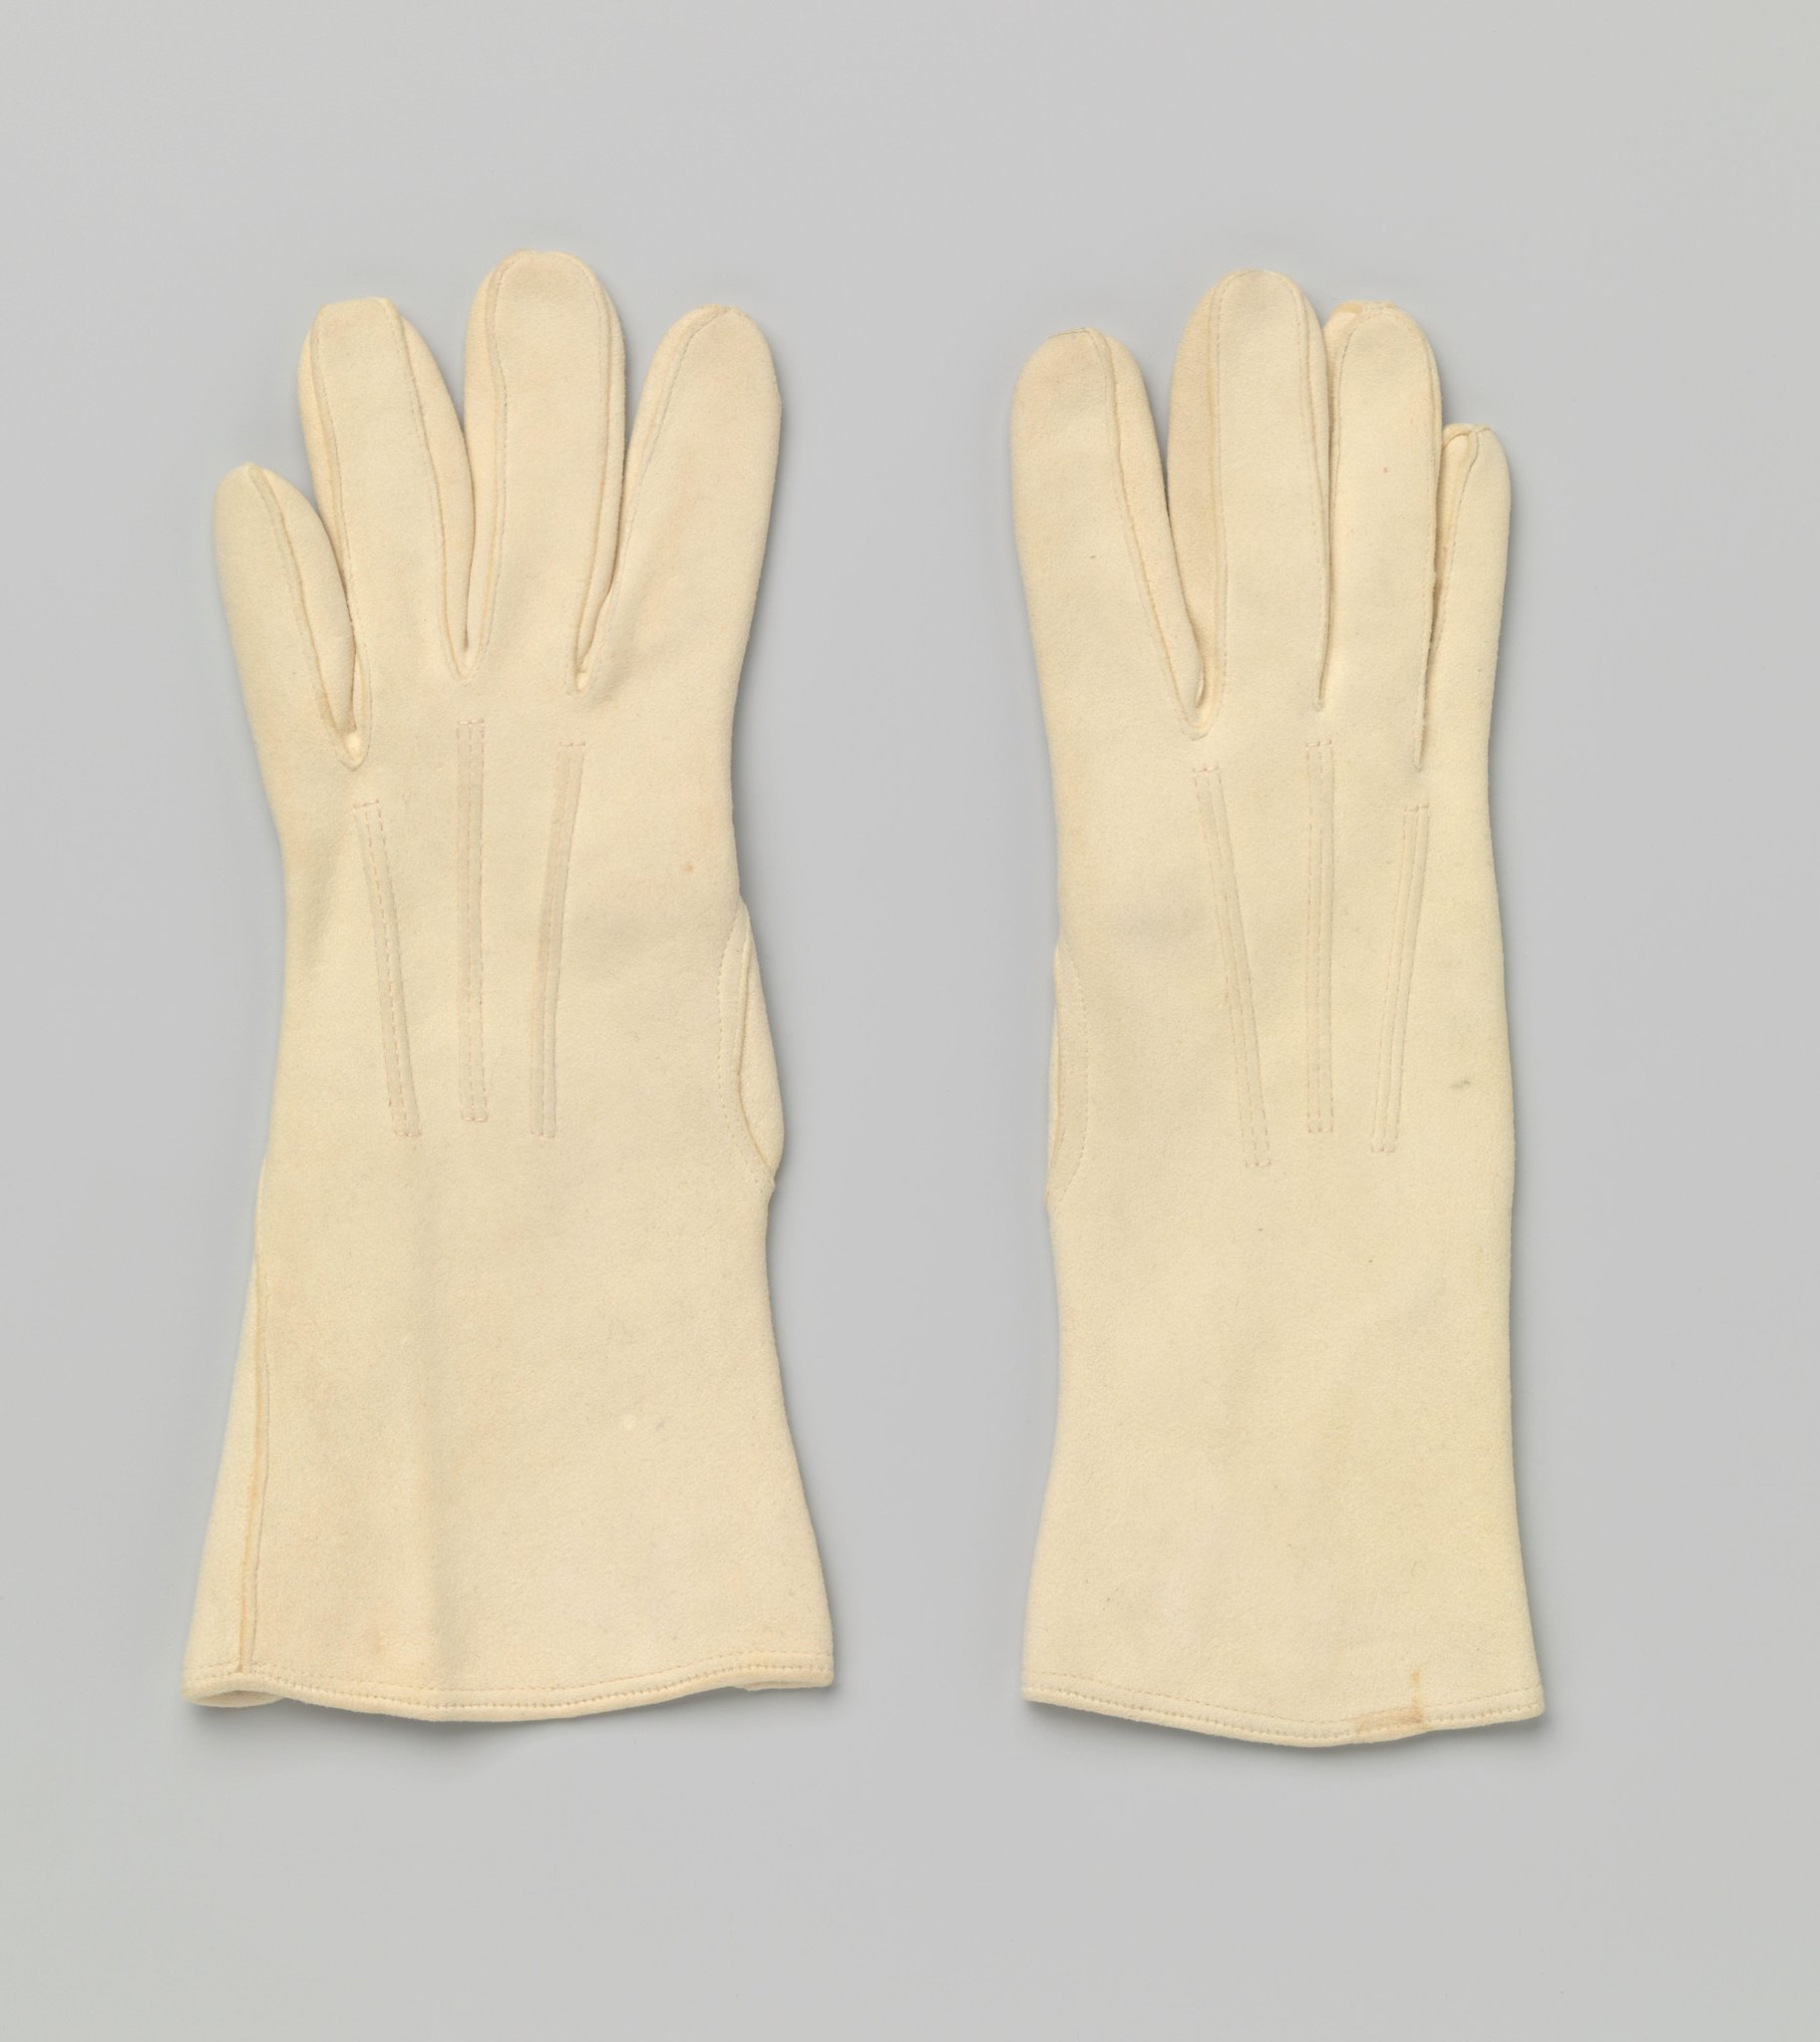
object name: glove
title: Handschoen van wit dik zeemleer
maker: m. laimböck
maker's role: modehuis, modewarenhuis, modewinkel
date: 1910-1930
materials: leather, mother of pearl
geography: tirol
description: Linkerhandschoen van wit dik zeemleer, op de rug drie uitstralende koorden, split met sluiting met twee knopen van parelmoer. Adres: gestempelde Z.. Oostenrijk, Tirol, mogelijk fa. Laimböck, ca. 1910-1930.